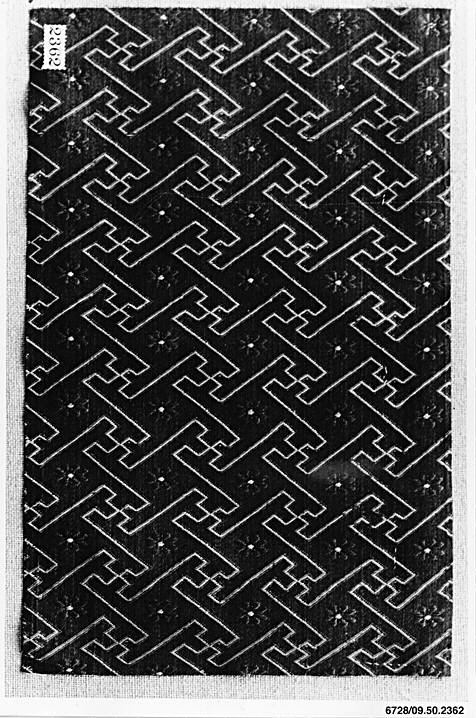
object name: piece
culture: japanese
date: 1801-1900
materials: silk